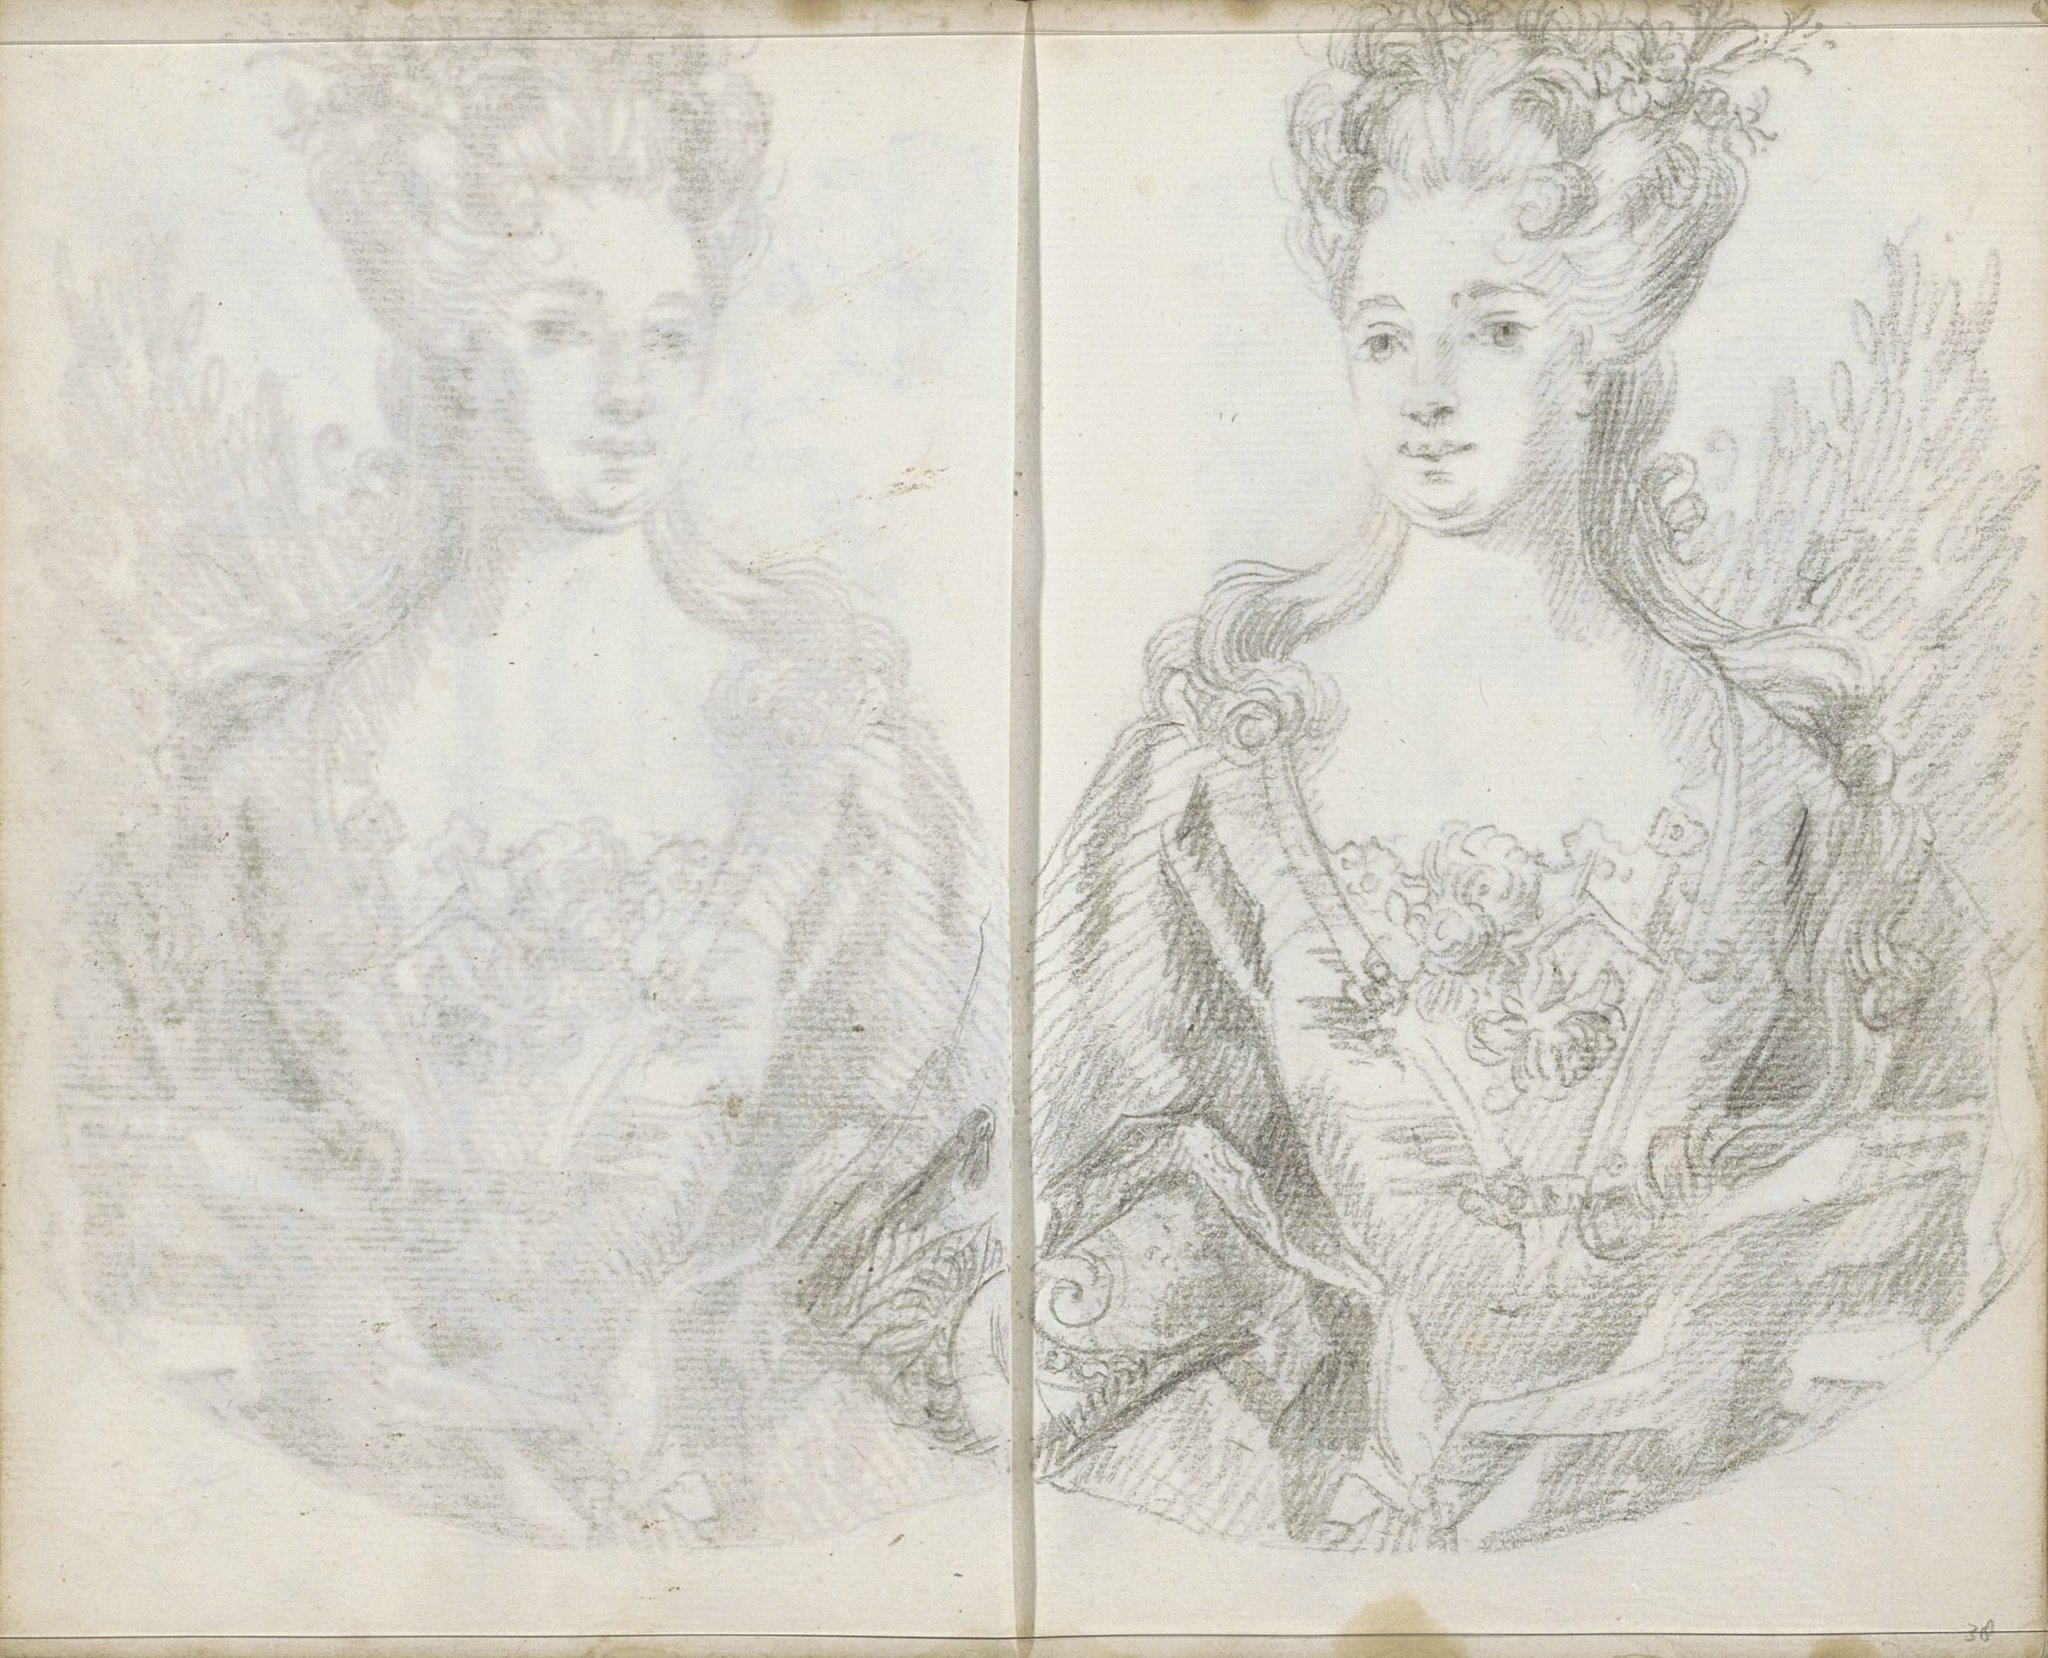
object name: sketchbook leaf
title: Portret van een vrouw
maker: petrus johannes van reysschoot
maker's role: draughtsman, print maker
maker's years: 1702-1772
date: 1710-1772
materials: chalk, paper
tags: anonymous historical person portrayed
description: Tekening in een ovaal. Blad 37 verso en 38 recto uit een schetsboek met 105 bladen.